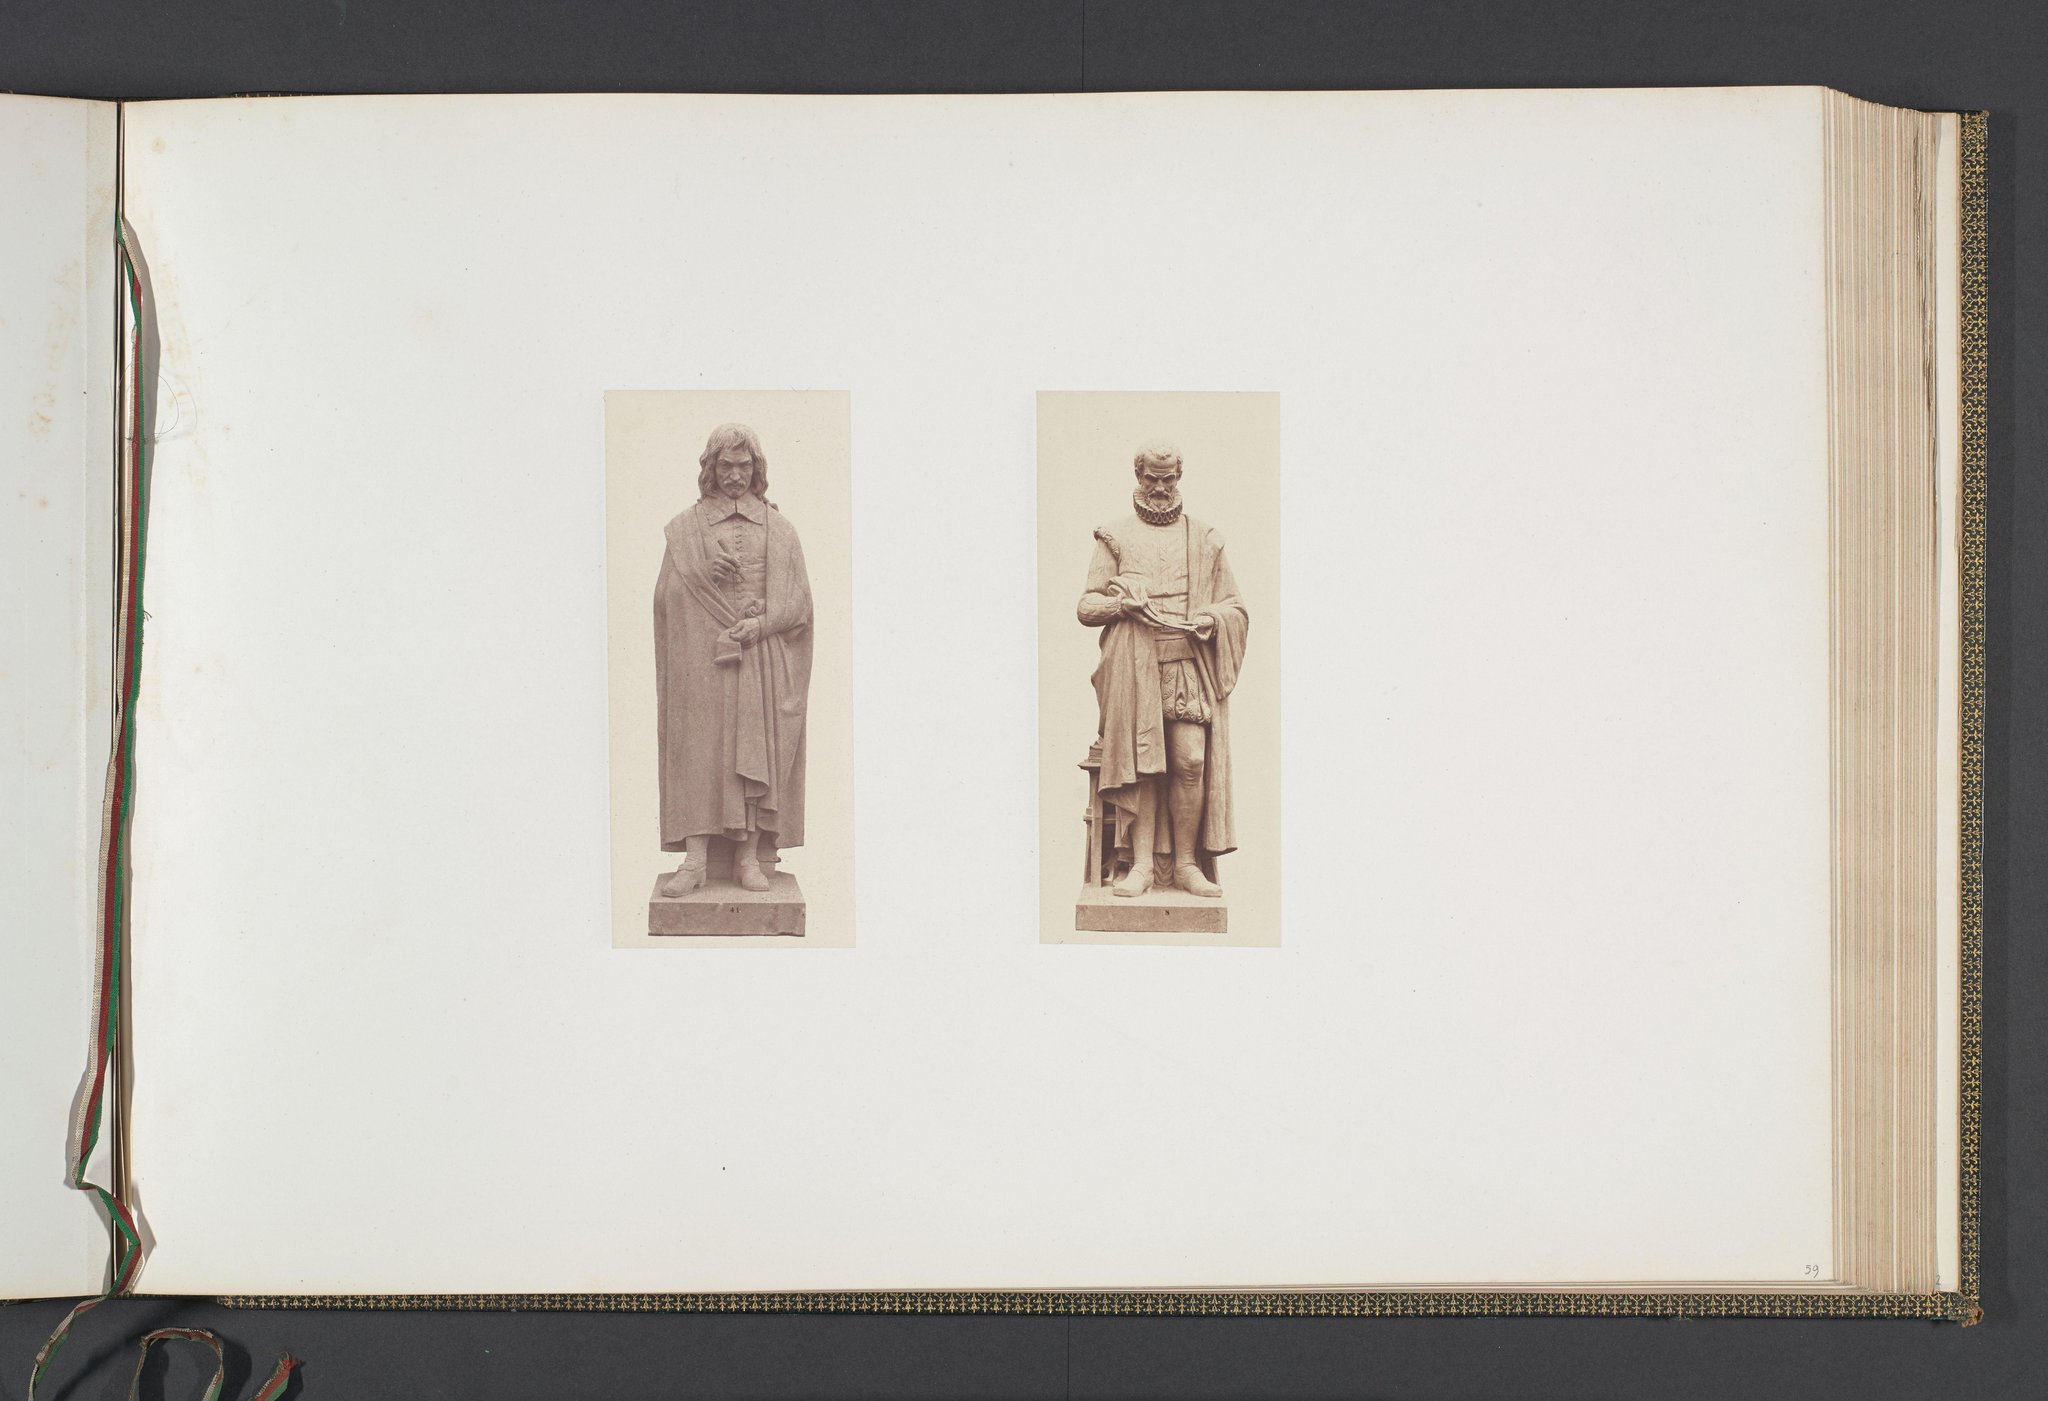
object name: photograph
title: Gipsmodellen voor beeldhouwwerken op het Palais du Louvre: links "Descartes" door Gabriel Joseph Garraud en rechts "Paré" door Michel-Pascal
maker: édouard denis baldus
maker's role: fotograaf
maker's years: 1813-1889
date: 1855-1857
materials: paper, photographic support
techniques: salted paper print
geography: paris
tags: rené descartes, piece of sculpture, reproduction of a piece of sculpture, permanent exhibition, museum, paris, tuileries palace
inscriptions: number: ‘41 en S’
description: Onderdeel van Réunion des Tuileries au Louvre 1852-1857, album 2.